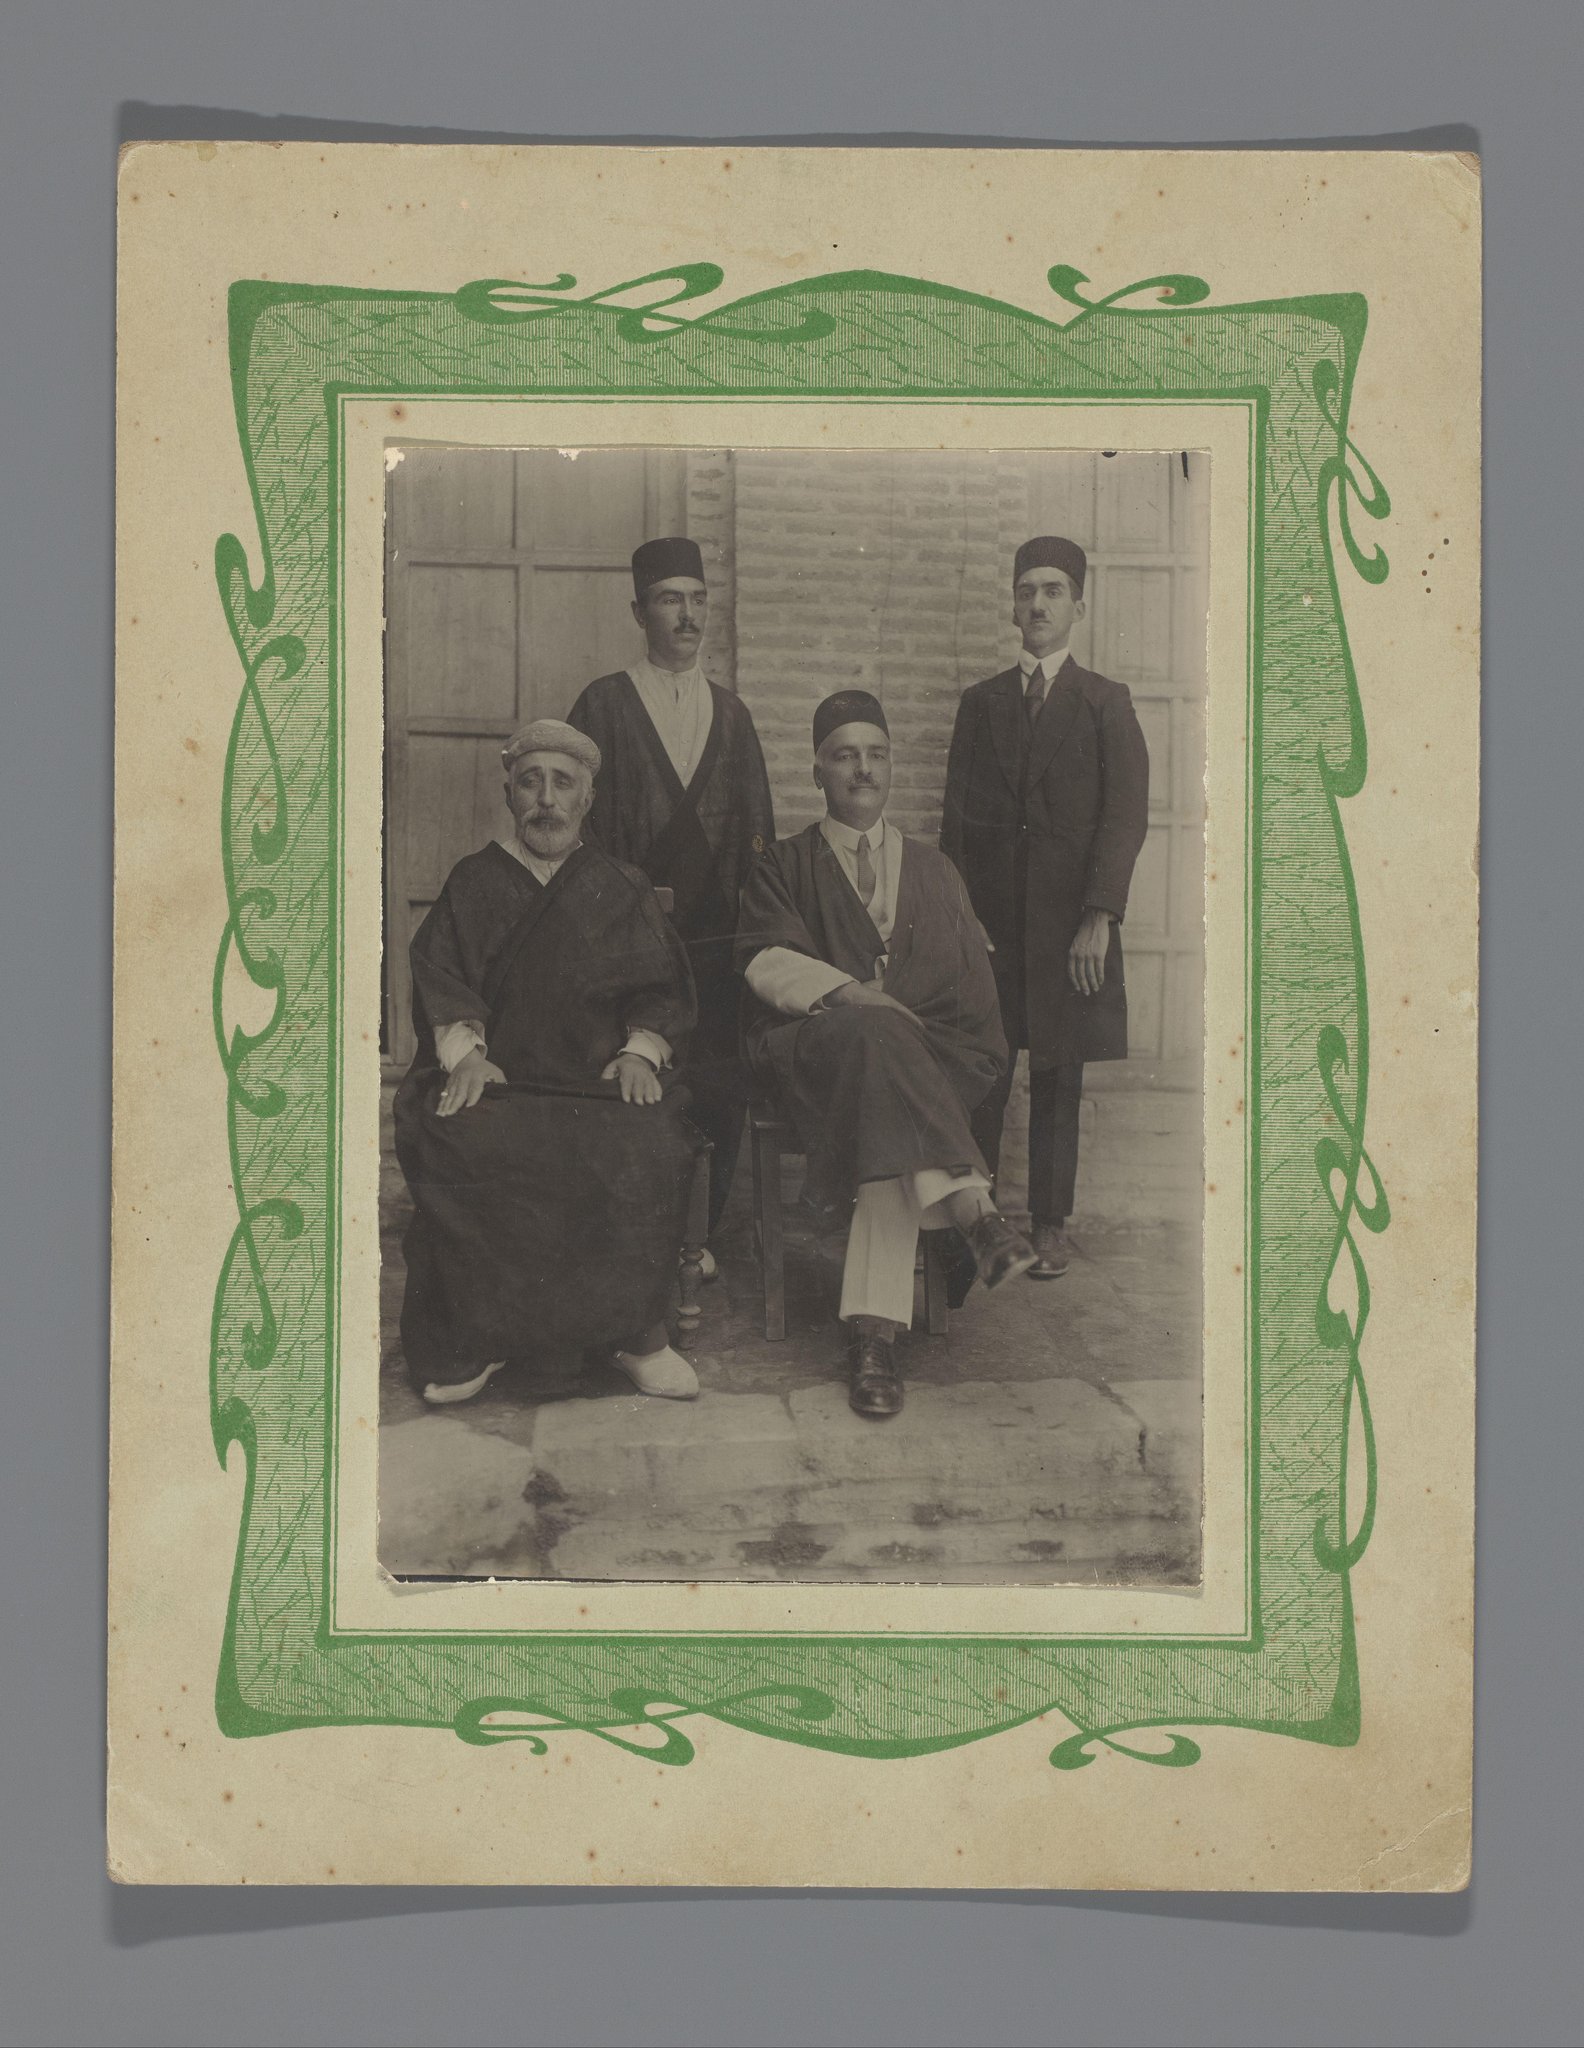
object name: photograph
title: Portret van Tavakoli (rechts) en 3 parlementariërs of ministers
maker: Anonymous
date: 1900-1950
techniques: gelatin silver print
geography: iran